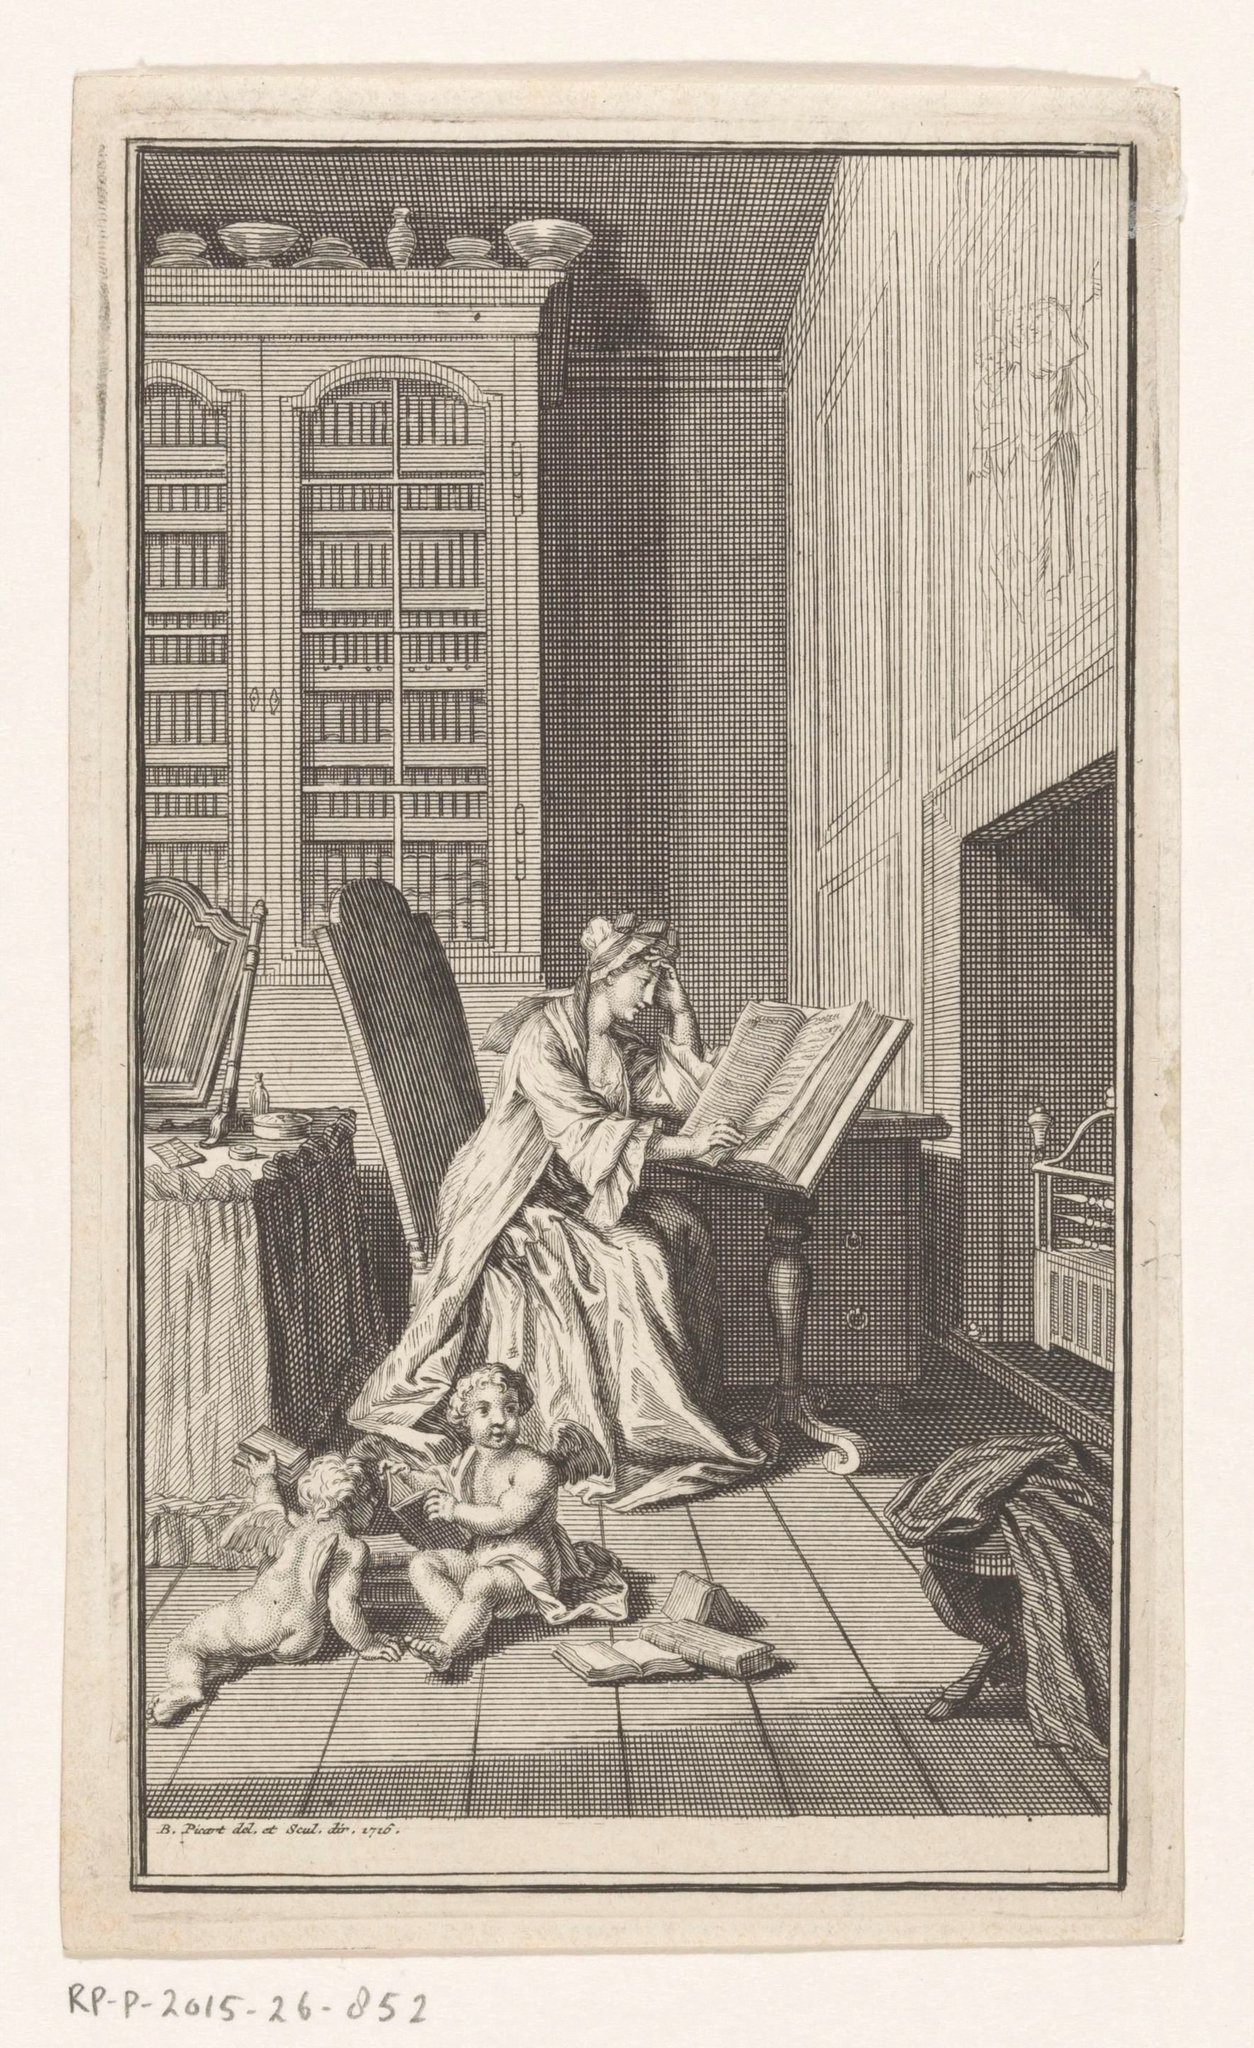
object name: print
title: Lezende vrouw in een interieur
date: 1719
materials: paper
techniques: engraving, etching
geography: amsterdam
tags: bookshelves, cupids: 'amores', 'amoretti', 'putti', lectern ~ reading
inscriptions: collector's mark: Lugt 2228, collector's mark: Lugt 4779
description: Een vrouw zit op een stoel met een hoge rugleuning te lezen in een foliant die openligt op een lessenaar. Met haar linkerhand ondersteunt ze haar hoofd, met de rechter slaat ze een pagina om. Tegen de muur van het vertrek staat een boekenkast met glazen deuren, op de voorgrond spelen twee putti met boeken.